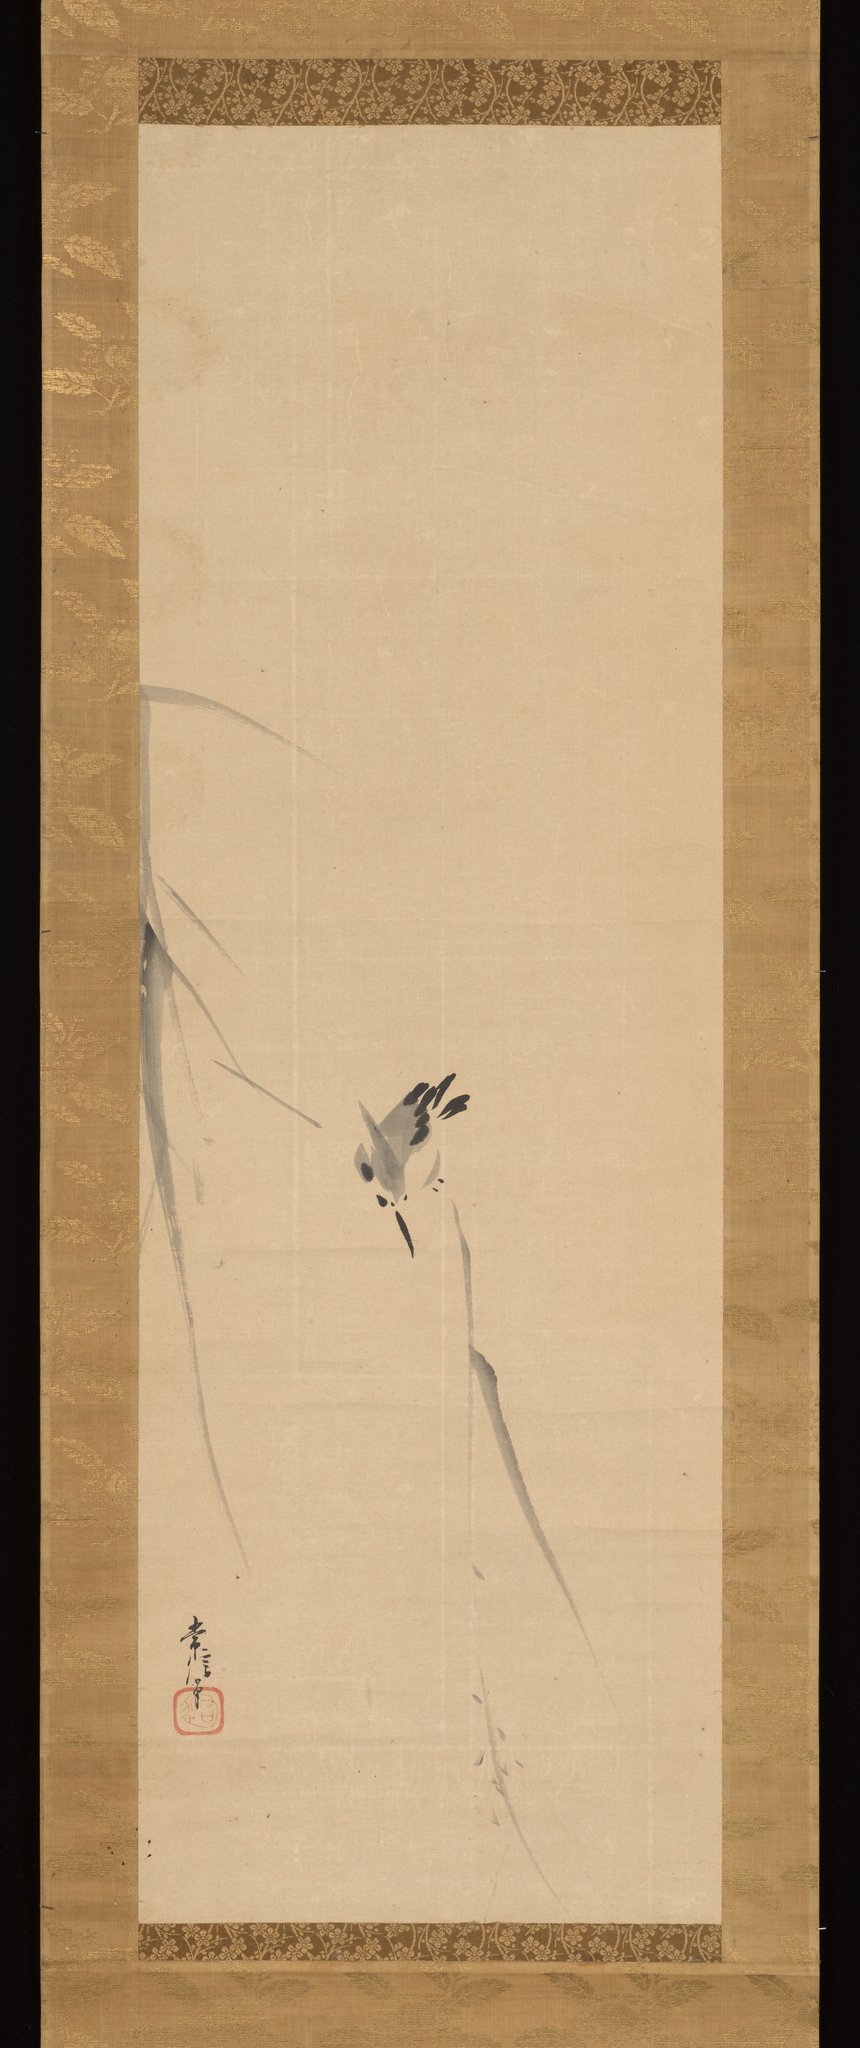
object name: hanging scroll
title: Kingfisher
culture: japanese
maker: kano tsunenobu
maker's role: artist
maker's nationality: japanese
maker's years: 1636-1713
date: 1636-1713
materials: ink, paper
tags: birds